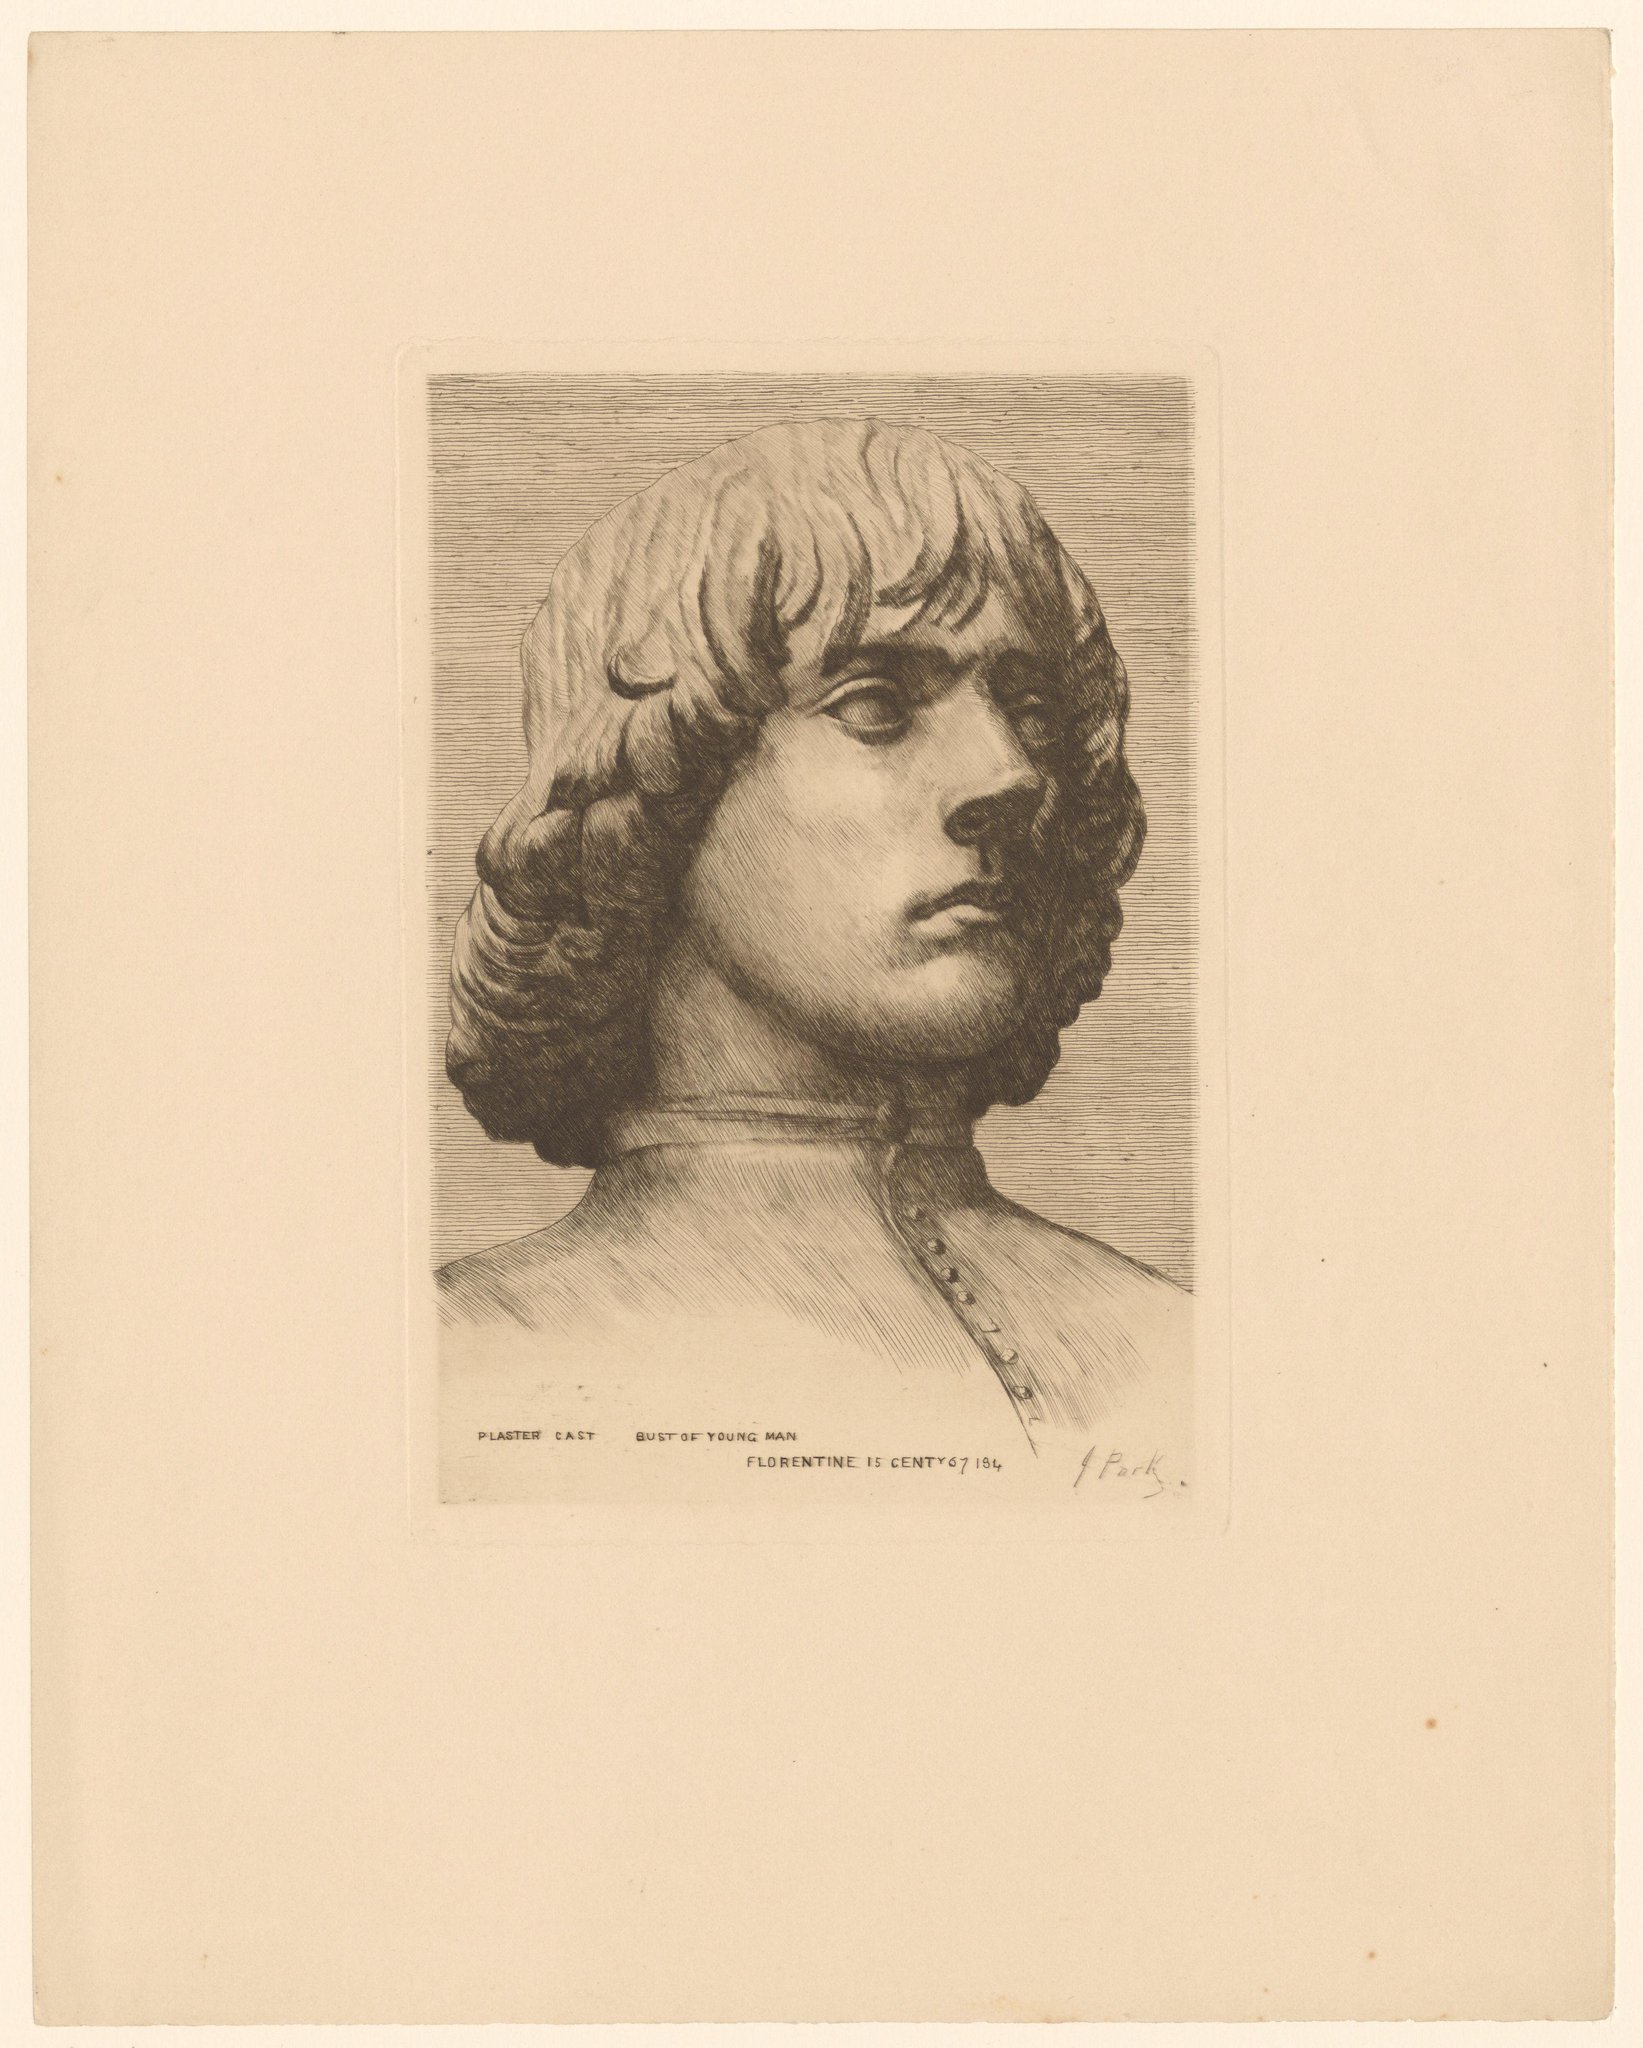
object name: print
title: Buste van jongeman, naar rechts kijkend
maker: john park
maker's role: print maker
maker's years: 1830-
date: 1876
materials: paper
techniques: etching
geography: london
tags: head (human) (+ three-quarter view), piece of sculpture, reproduction of a piece of sculpture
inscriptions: collector's mark: Lugt 2228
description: Prent is deel van een groep prenten gemaakt door leerlingen van Alphonse Legros, naar kunstwerken in het Victoria & Albert Museum.